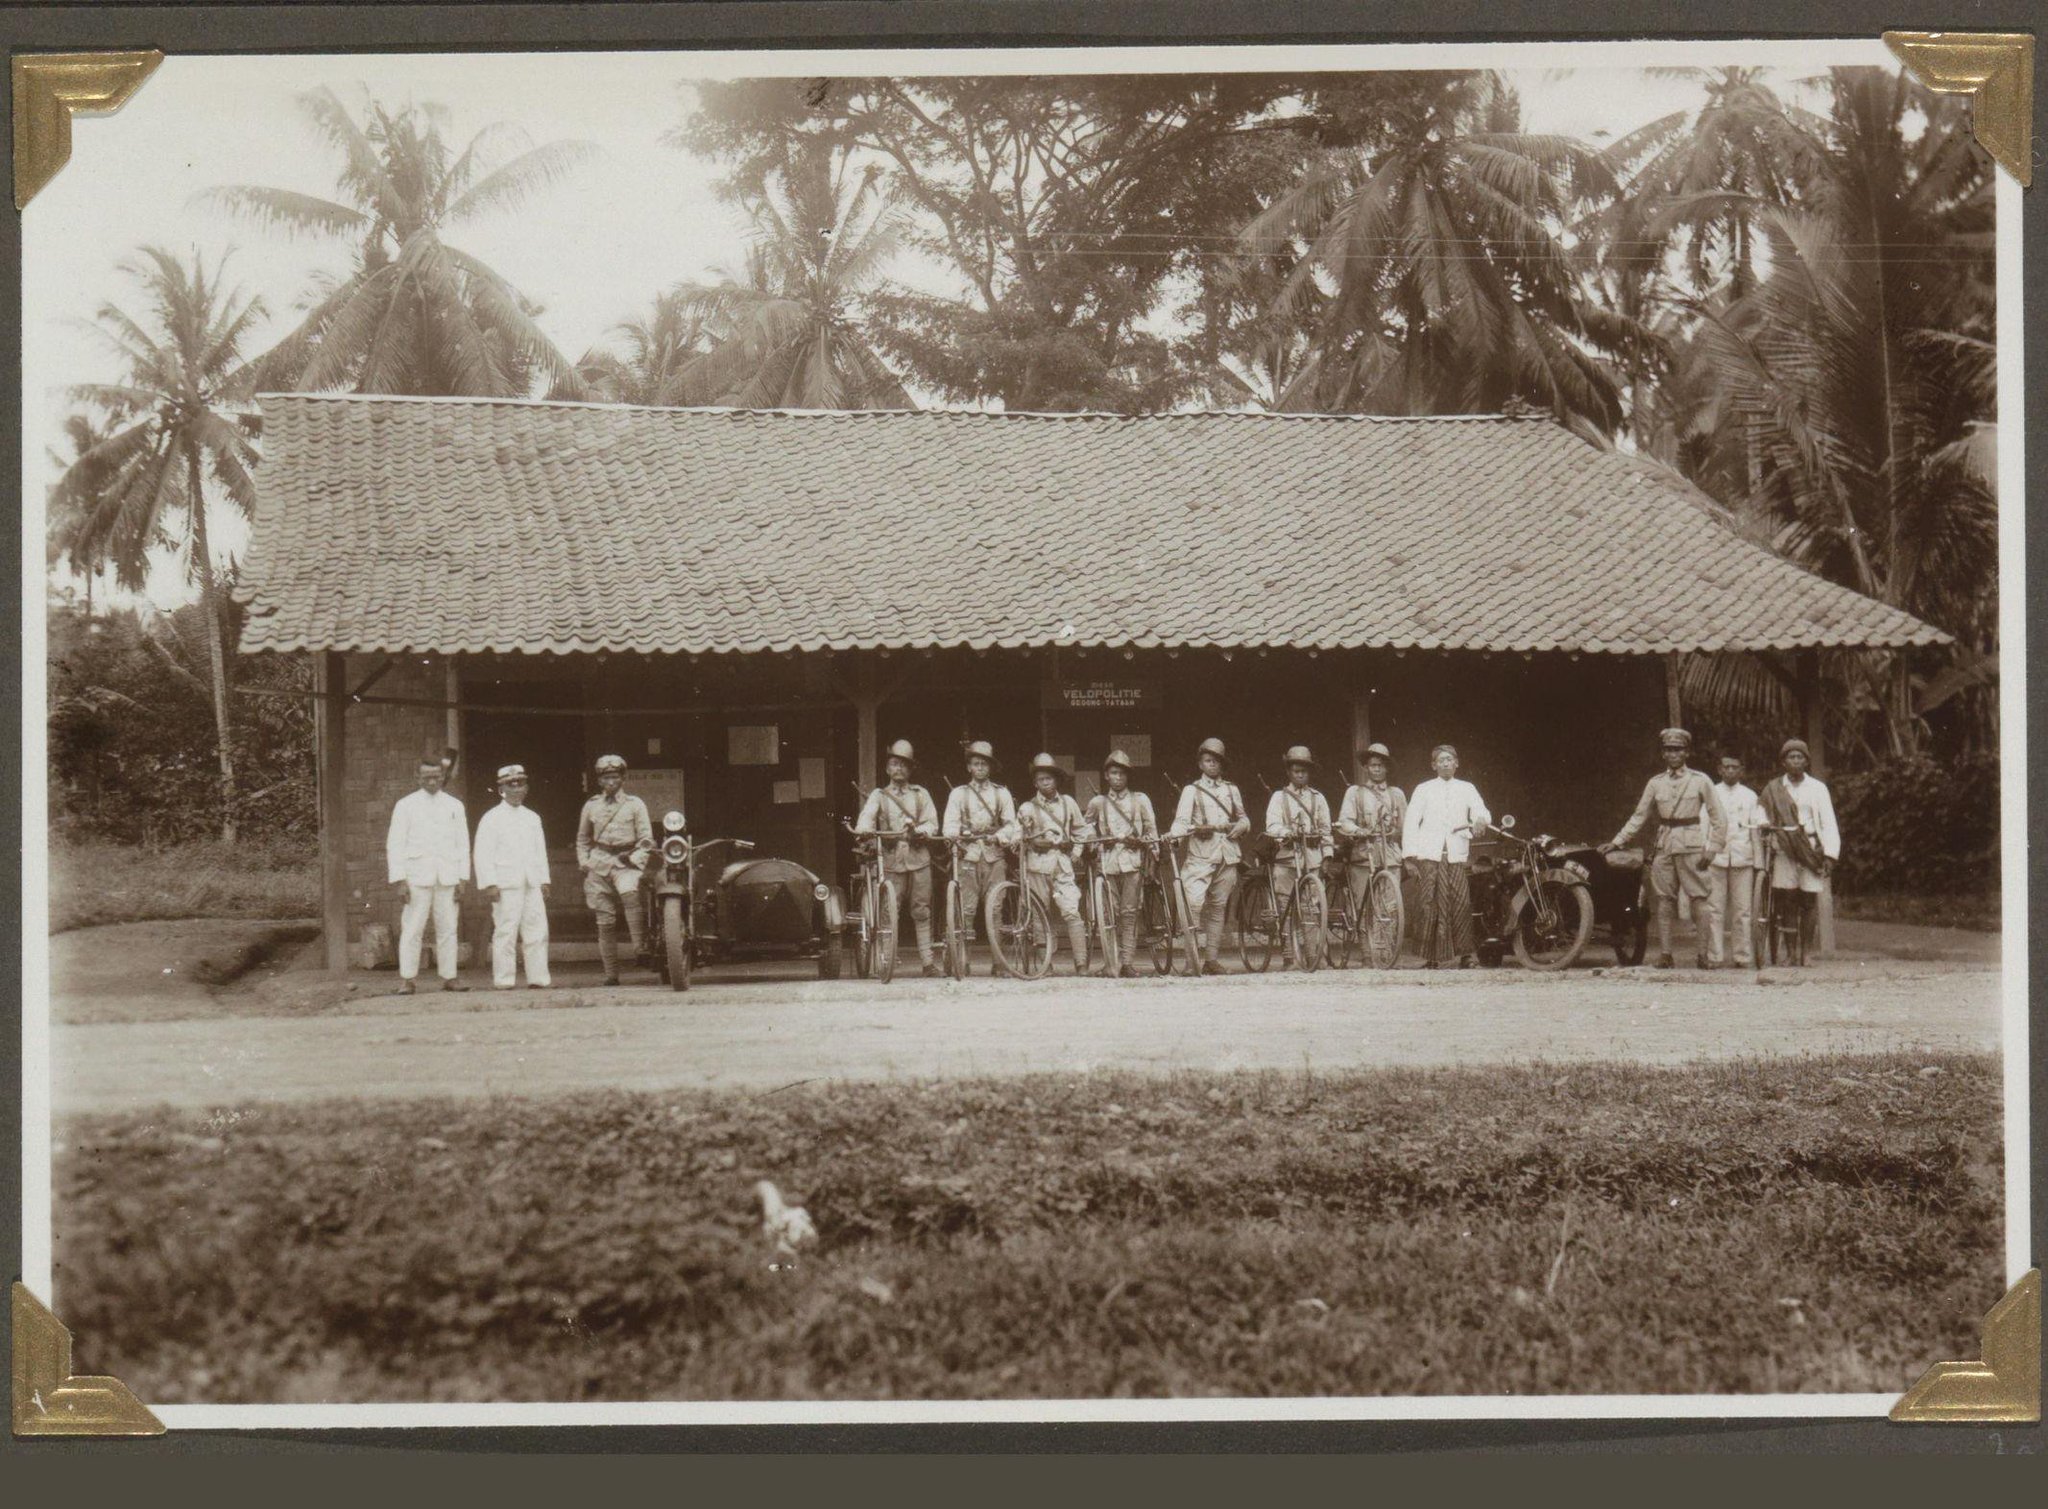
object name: photograph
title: Groepsportret van het onderdetachement 'Gedong Tataän' van de politie in Lampong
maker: Anonymous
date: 1932-1933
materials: photographic support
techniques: gelatin silver print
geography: lampung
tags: motor-cycles and other two-wheeled motor-vehicles, bicycle, police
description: Onderdeel van Herinneringsalbum voor F.J. Junius, vertrekkend resident van Lampong (Zuid-Sumatra).